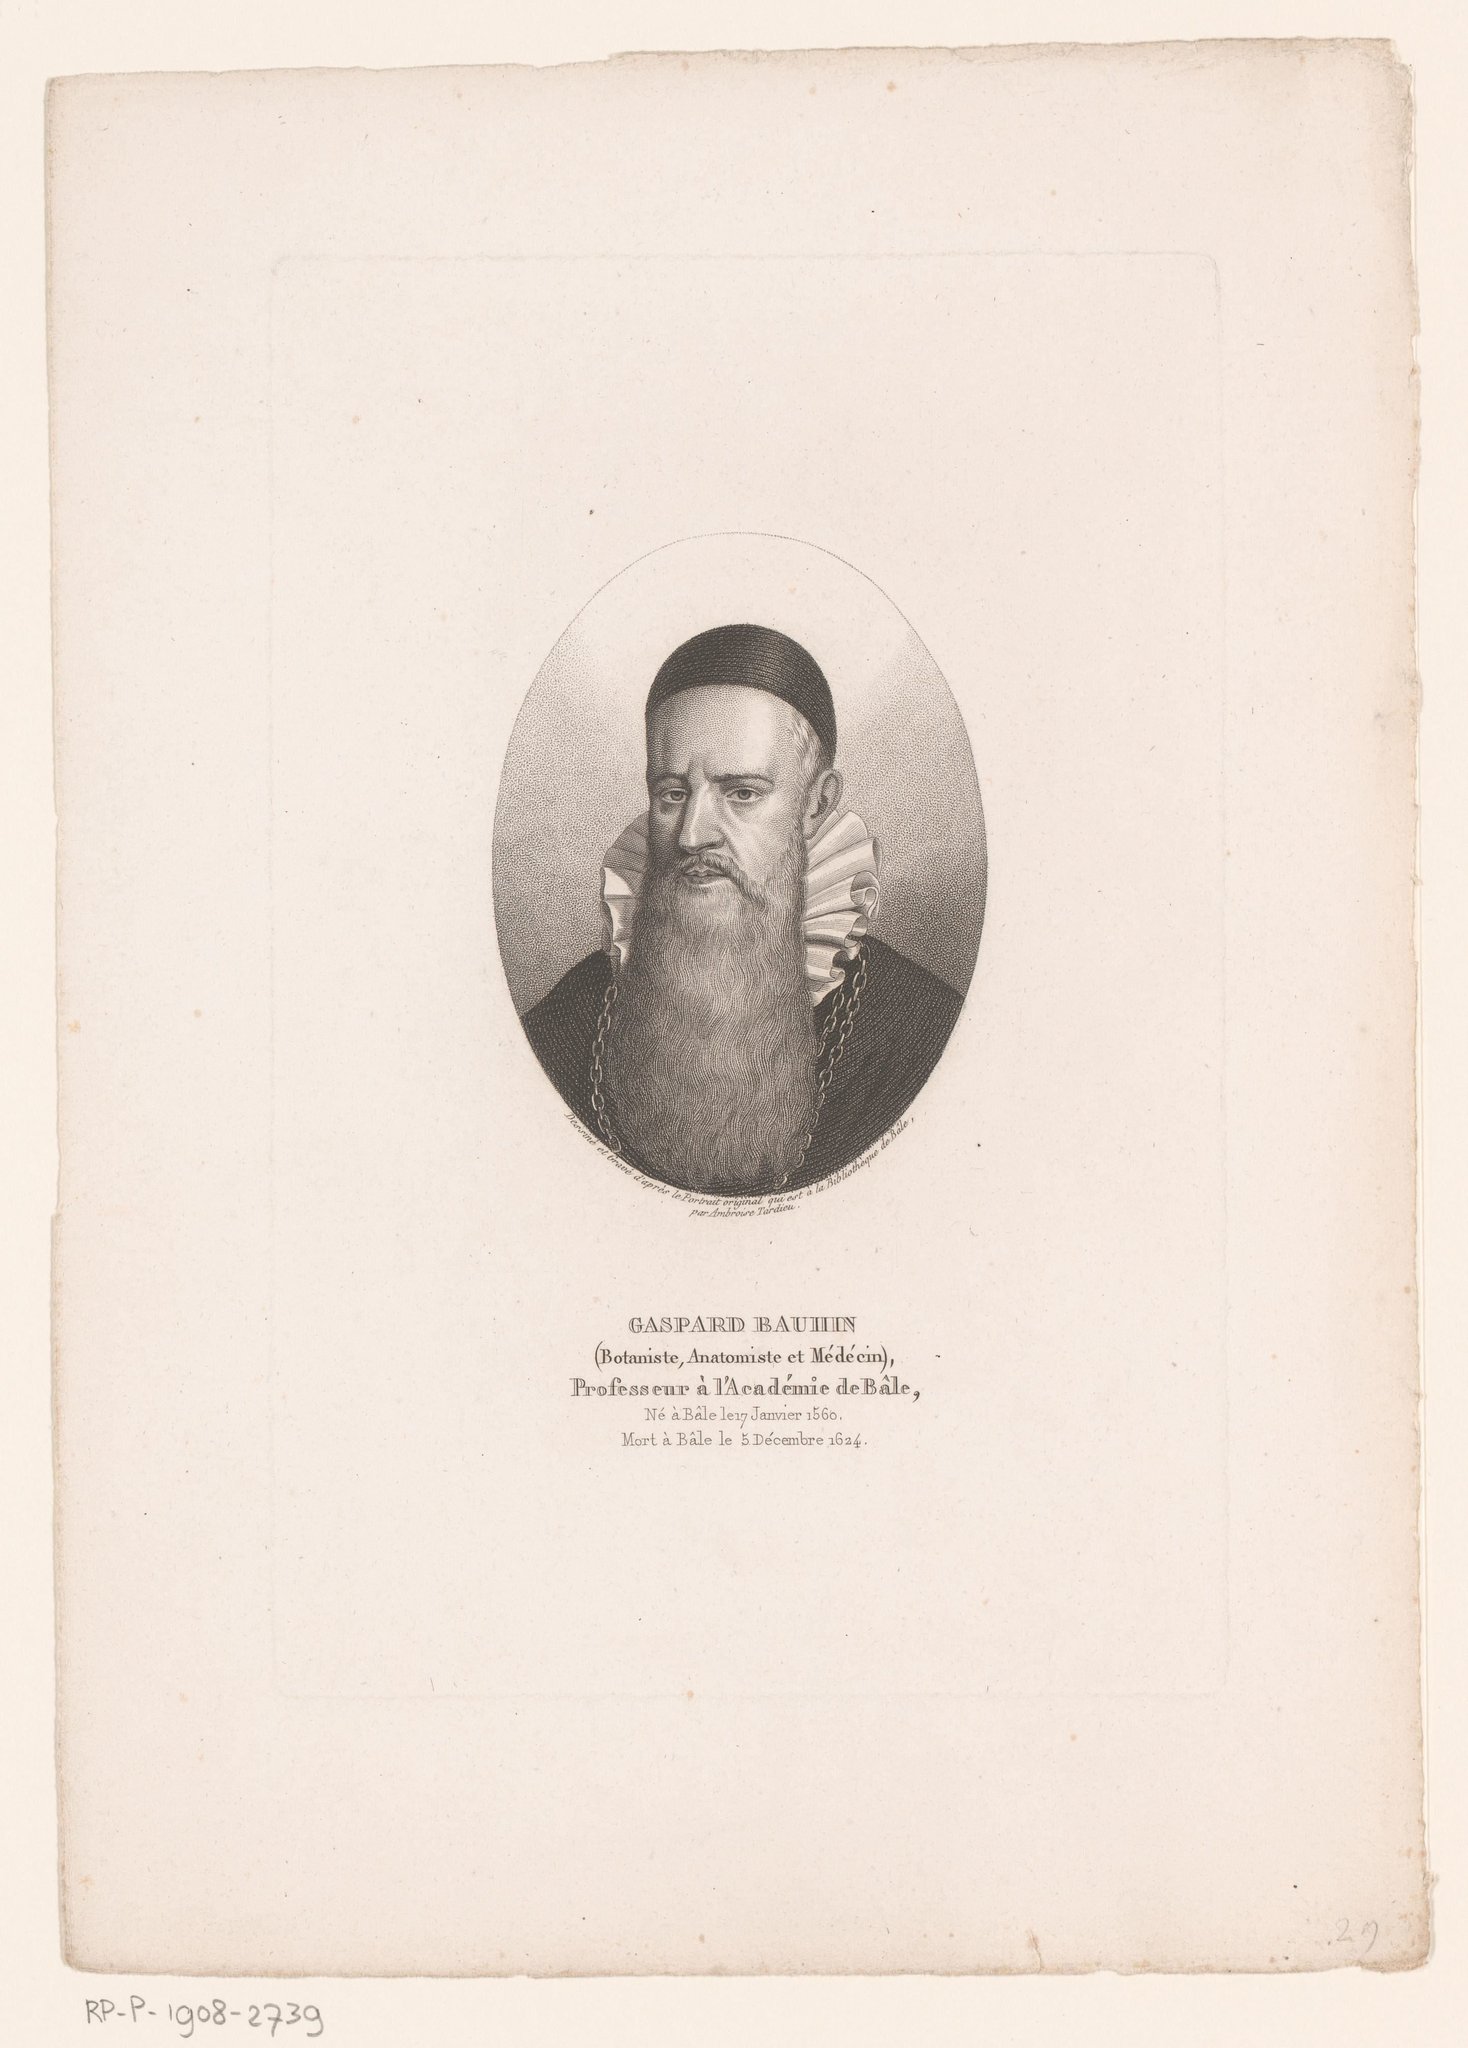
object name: print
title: Portret van Caspar Bauhin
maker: ambroise tardieu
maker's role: print maker, printer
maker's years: 1788-1841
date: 1820-1828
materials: paper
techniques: engraving, etching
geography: paris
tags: historical persons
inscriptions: collector's mark: Lugt 2228